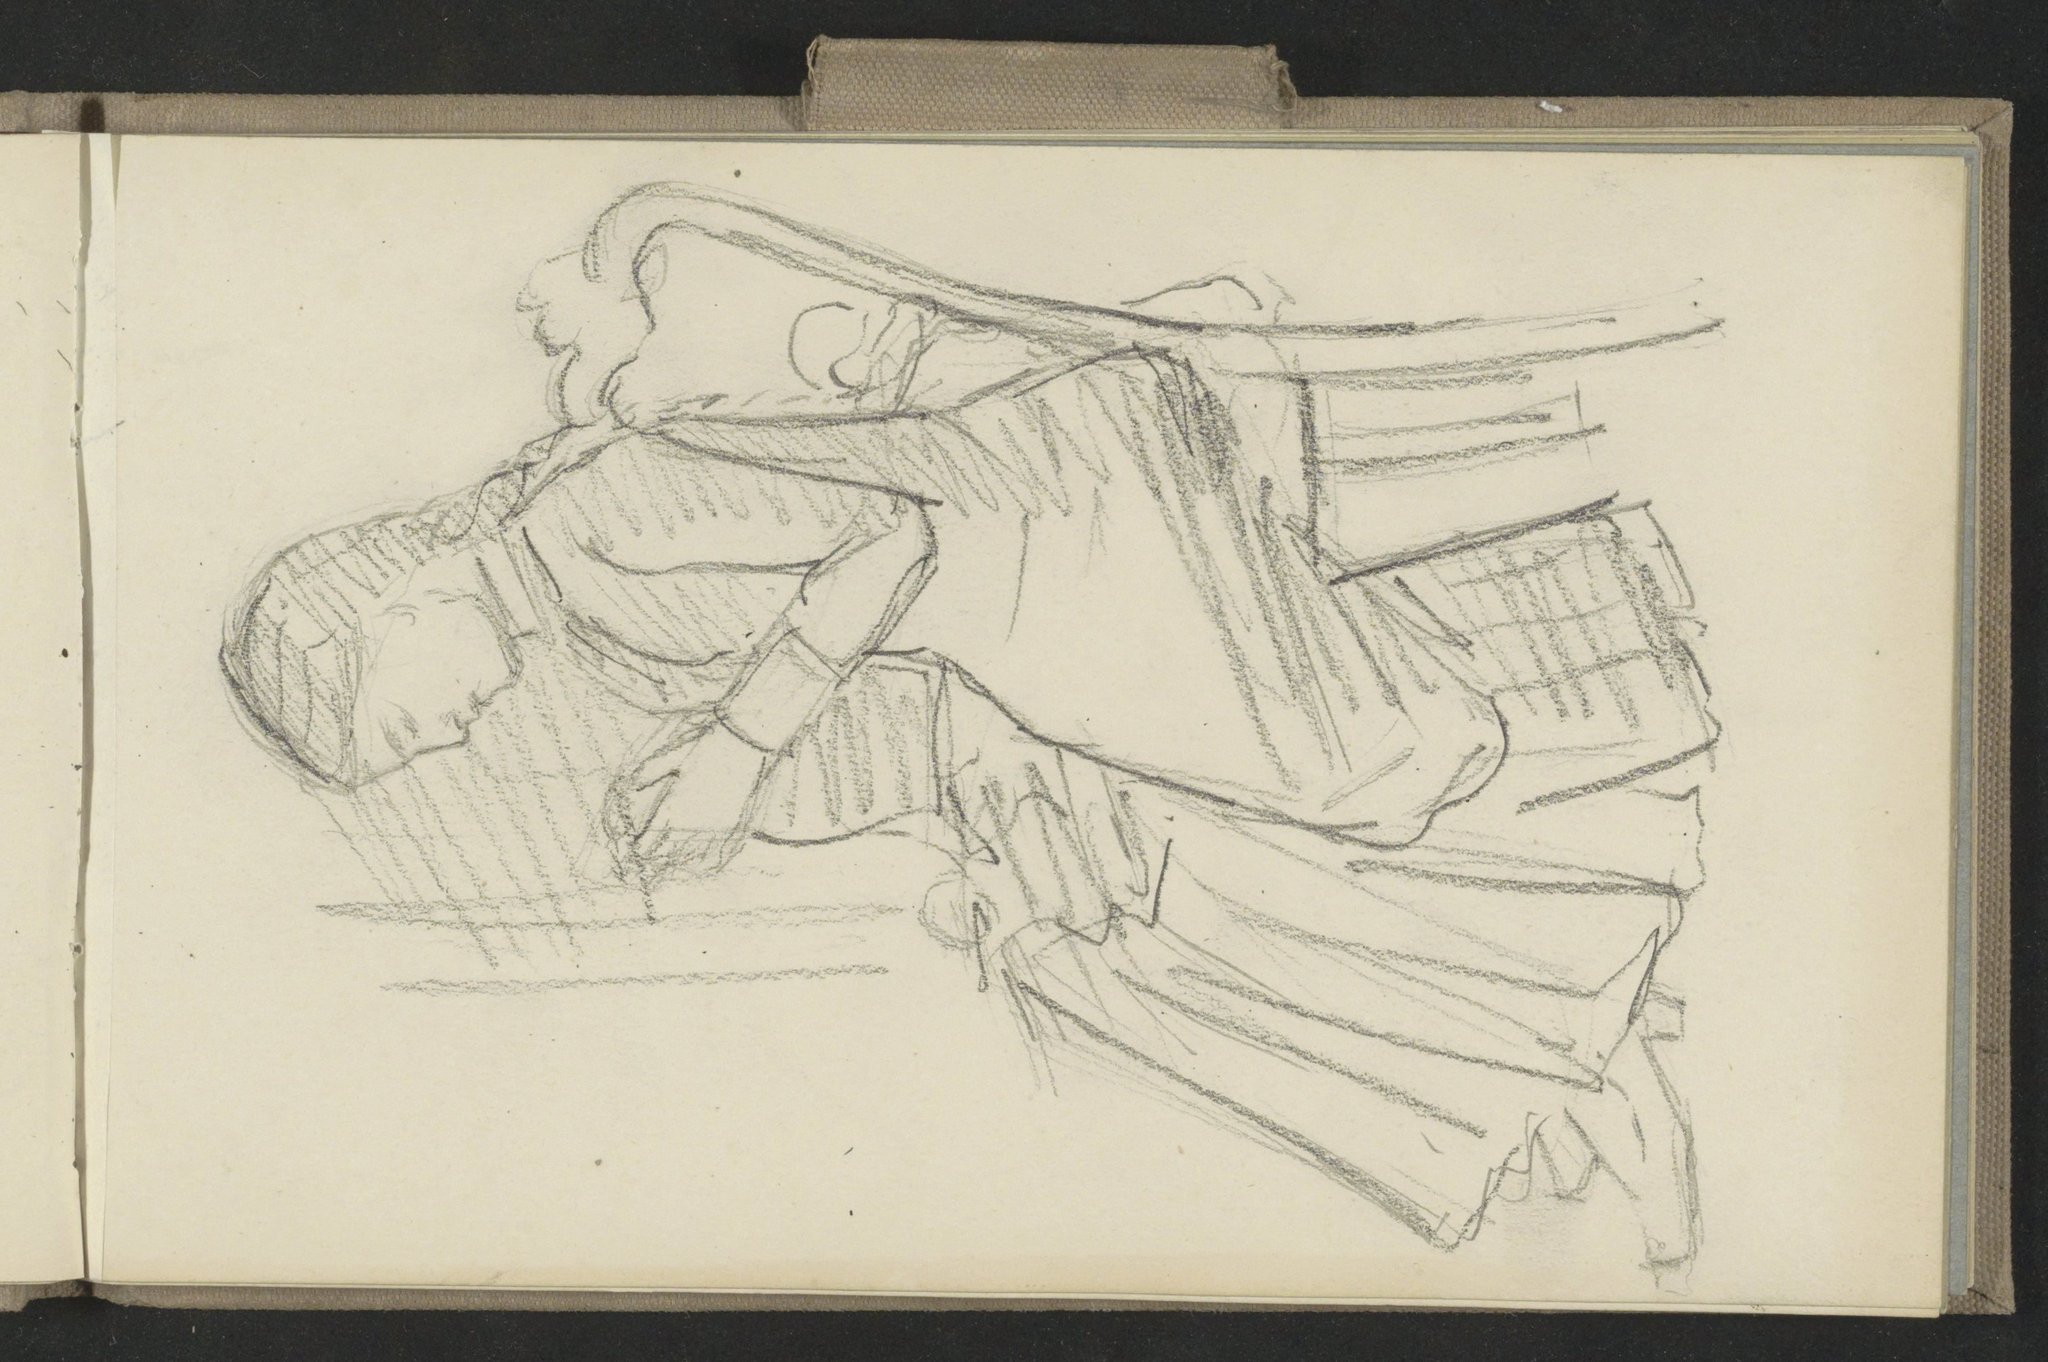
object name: sketchbook leaf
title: Handwerkende jonge vrouw op een stoel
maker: jozef israëls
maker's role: draughtsman, painter, print maker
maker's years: 1824-1911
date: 1834-1911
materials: paper, pencil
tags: sitting figure - aa - female human figure, home sewing; repair of clothes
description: Blad 9 recto uit een schetsboek met 26 bladen.